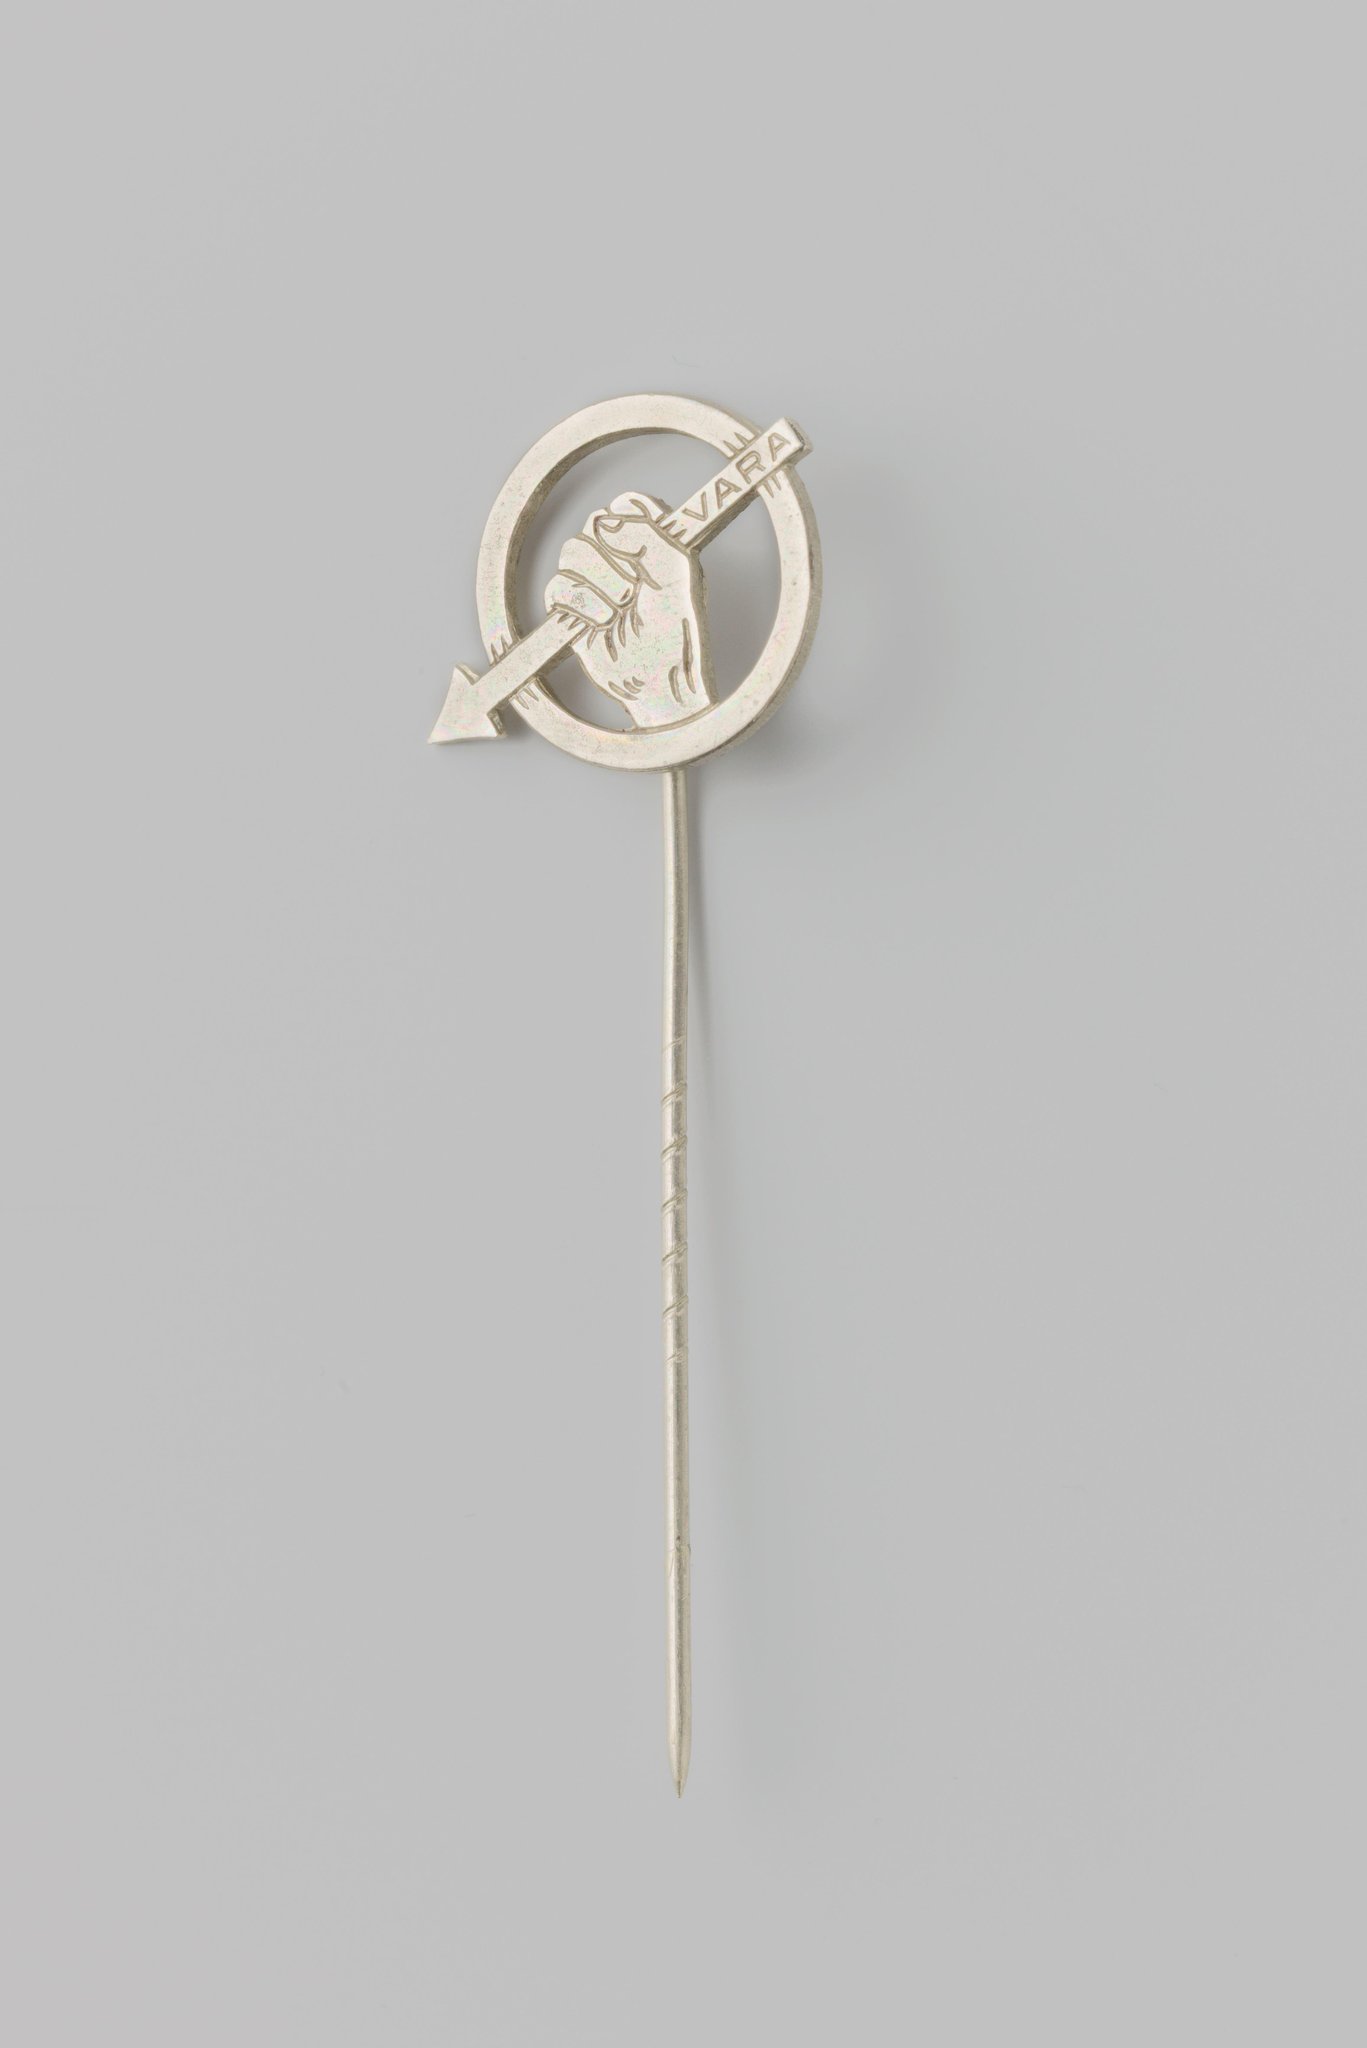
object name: pin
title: VARA steekspeldje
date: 1900-1982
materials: metal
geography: hilversum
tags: netherlands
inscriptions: inscription: ‘VARA’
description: In the 1920s the various Dutch religious and political streams established separate radio organisations. The Protestant NCRV started in 1924, the Catholic KRO and the Socialist VARA in 1925, the Nonconformist Protestant VPRO in 1926 and the Liberal AVRO in 1927. All these organisations had one thing in common: lack of funds. There were constant money-raising activities and membership drives.